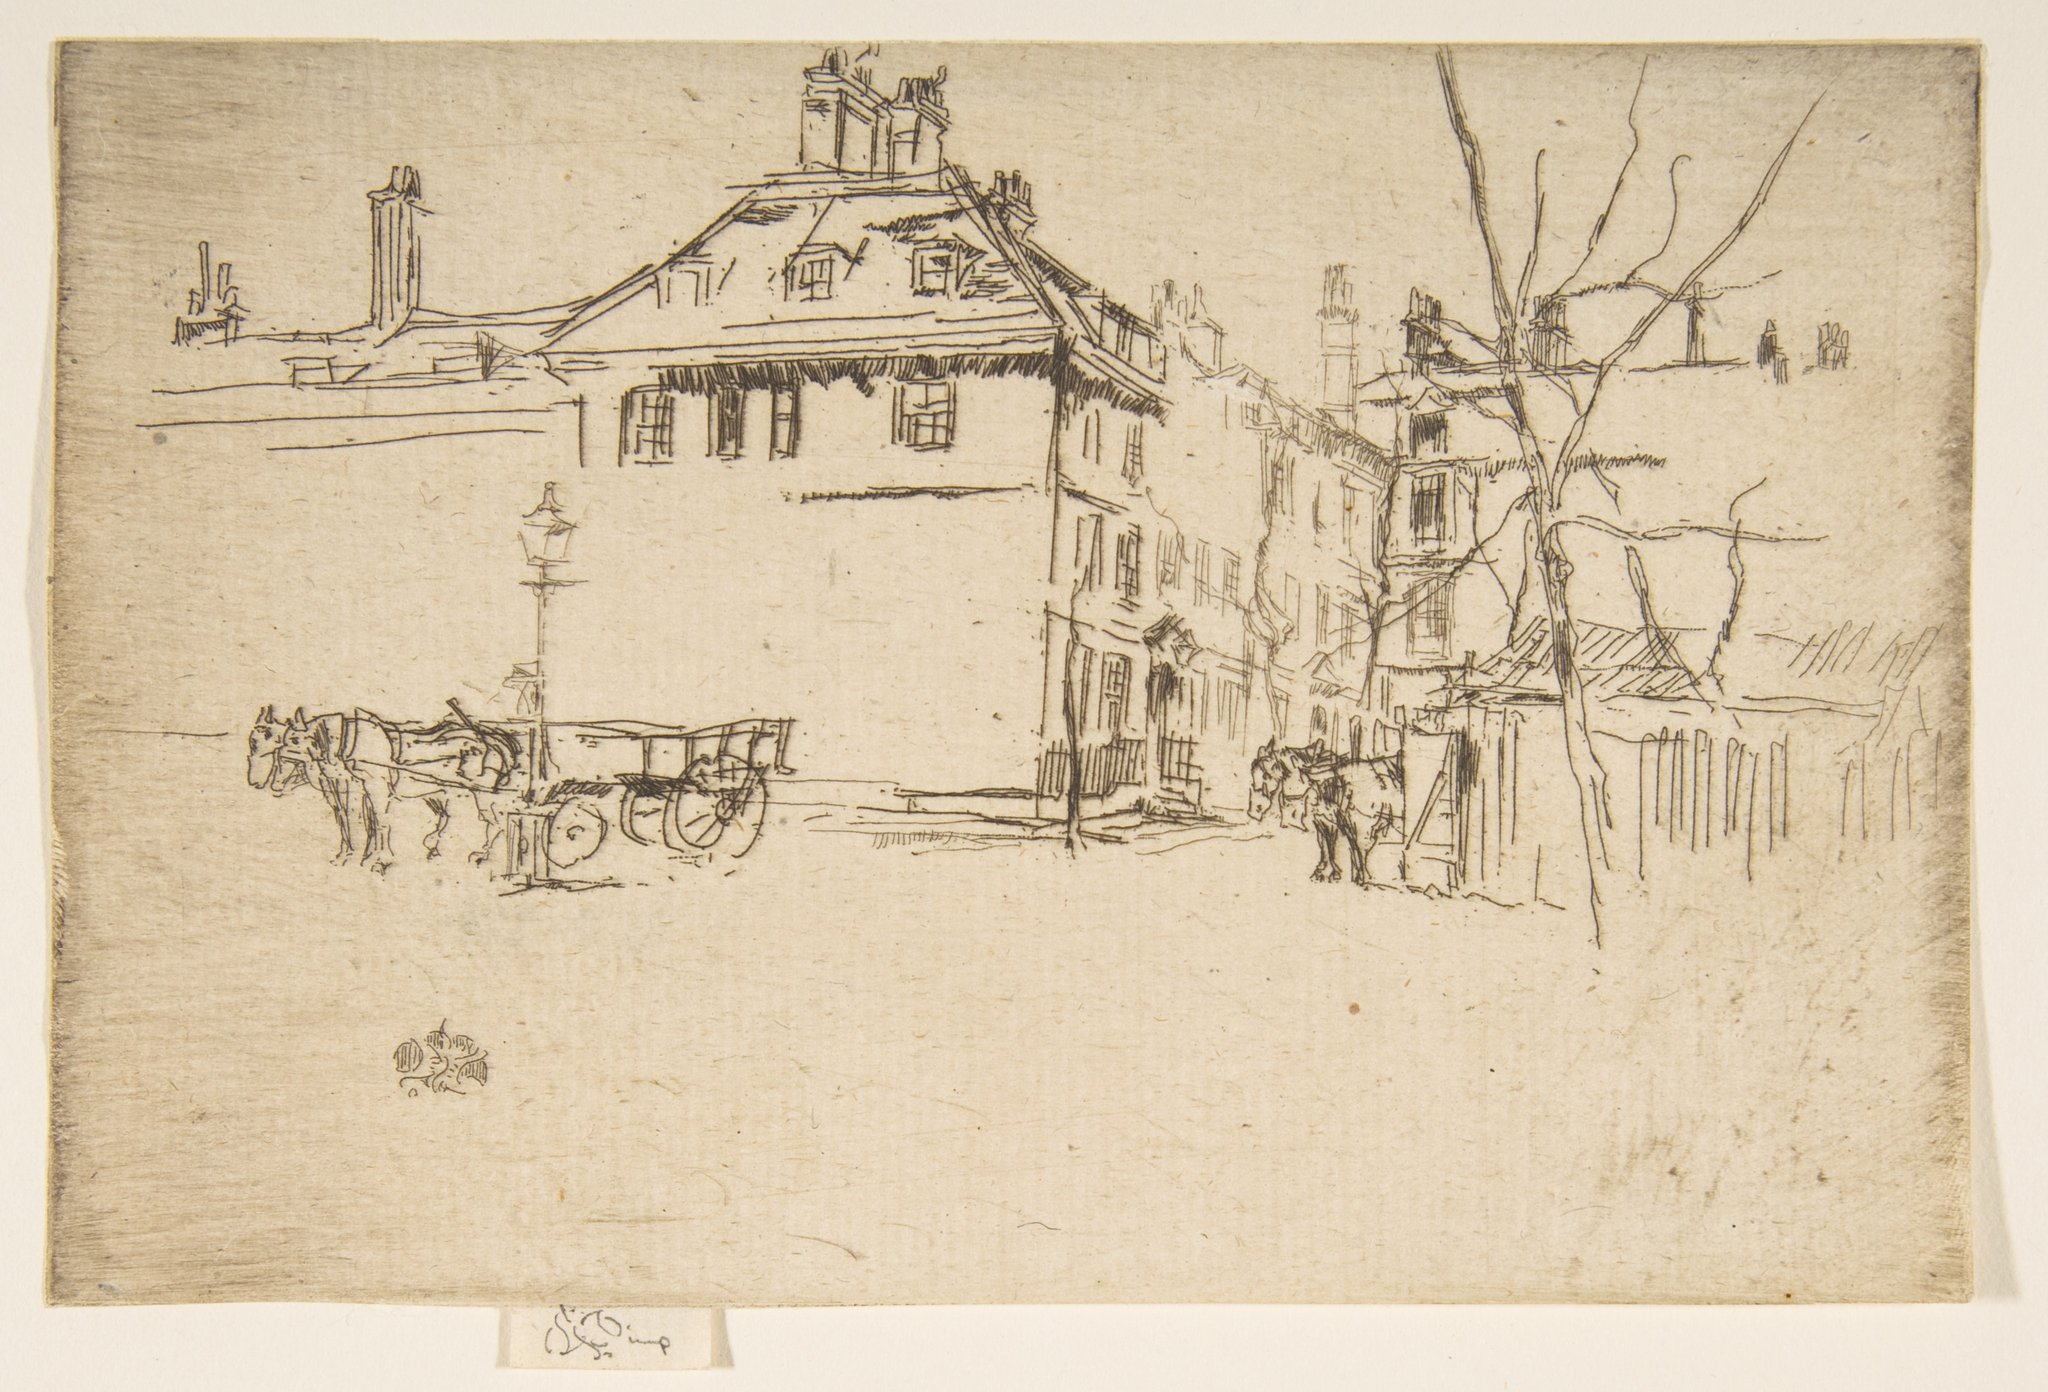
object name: print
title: Temple (The Temple)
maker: james mcneill whistler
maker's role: artist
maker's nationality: american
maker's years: 1834-1903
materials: ink, paper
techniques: etching, printing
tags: temples,carriages,london